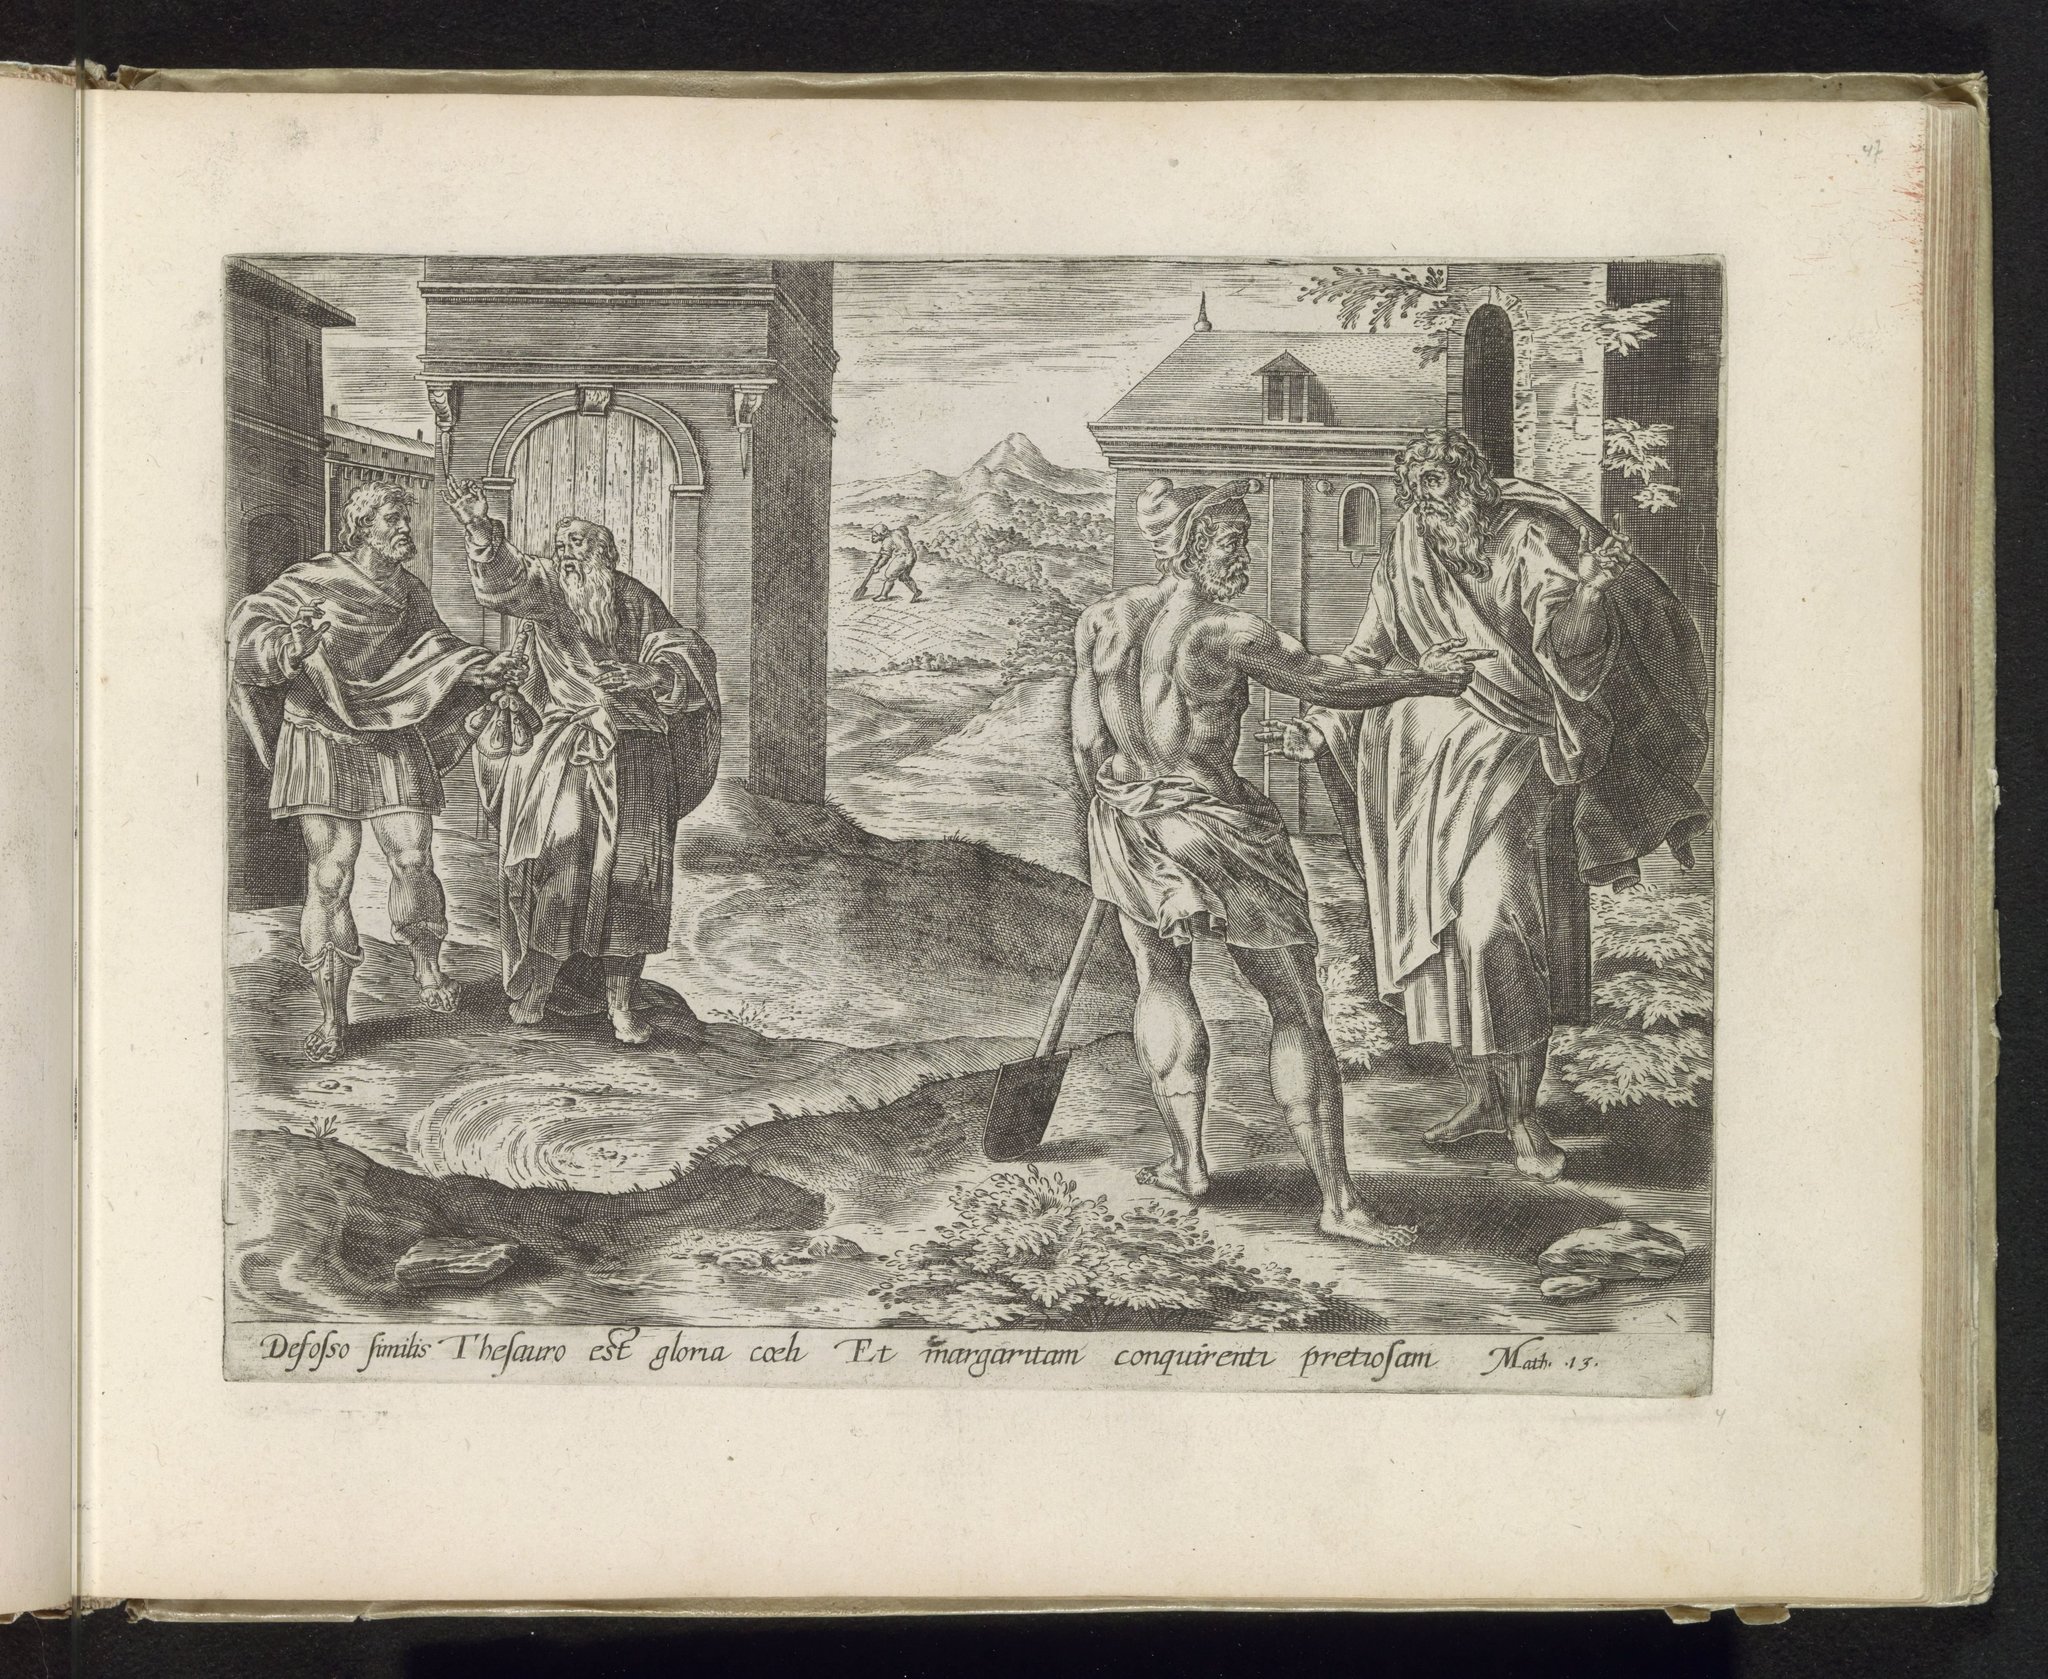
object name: album leaf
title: Thesaurus novi Testamenti elegantissimis iconibus expressus continens historias atque miracula doni nostri Iesu Christi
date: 1585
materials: paper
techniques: engraving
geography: antwerp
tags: 'the kingdom of heaven is like treasure hidden in a field' ~ proverbial saying of christ (matthew 13:44)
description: Een man koopt nadat hij in een akker een schat heeft gevonden de akker van de eigenaar. Op de achtergrond is te zien hoe de man de schat vindt en weer begraaft. Op de voorgrond links staat de man met een stokkenbeurs in de hand om te onderhandelen en de akker te kopen. Onder de voorstelling een verwijzing in het Latijn naar de Bijbeltekst in Mat. 13. Deze prent maakt deel uit van een album.